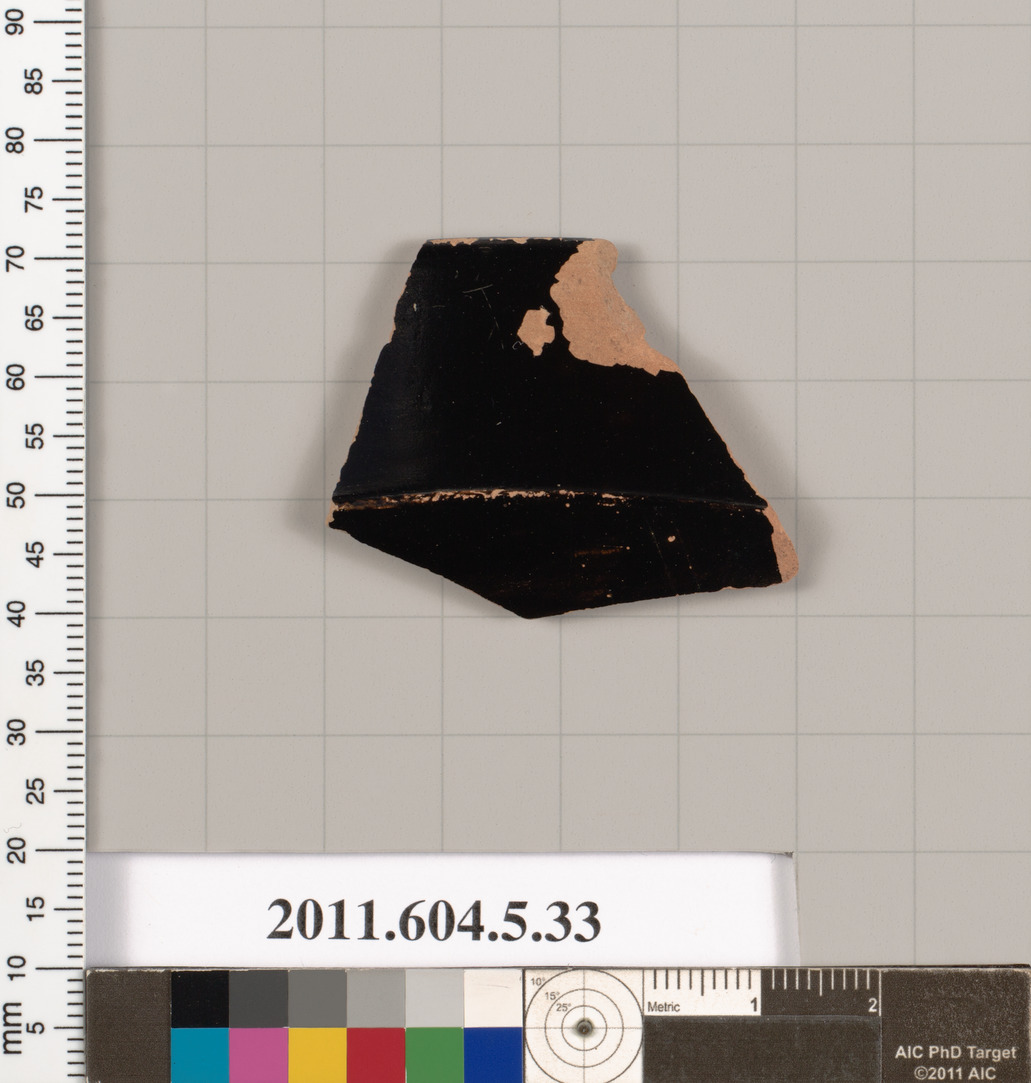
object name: kylix fragment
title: Terracotta rim fragment of a kylix (drinking cup)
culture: greek, attic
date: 500-401 BCE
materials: terracotta